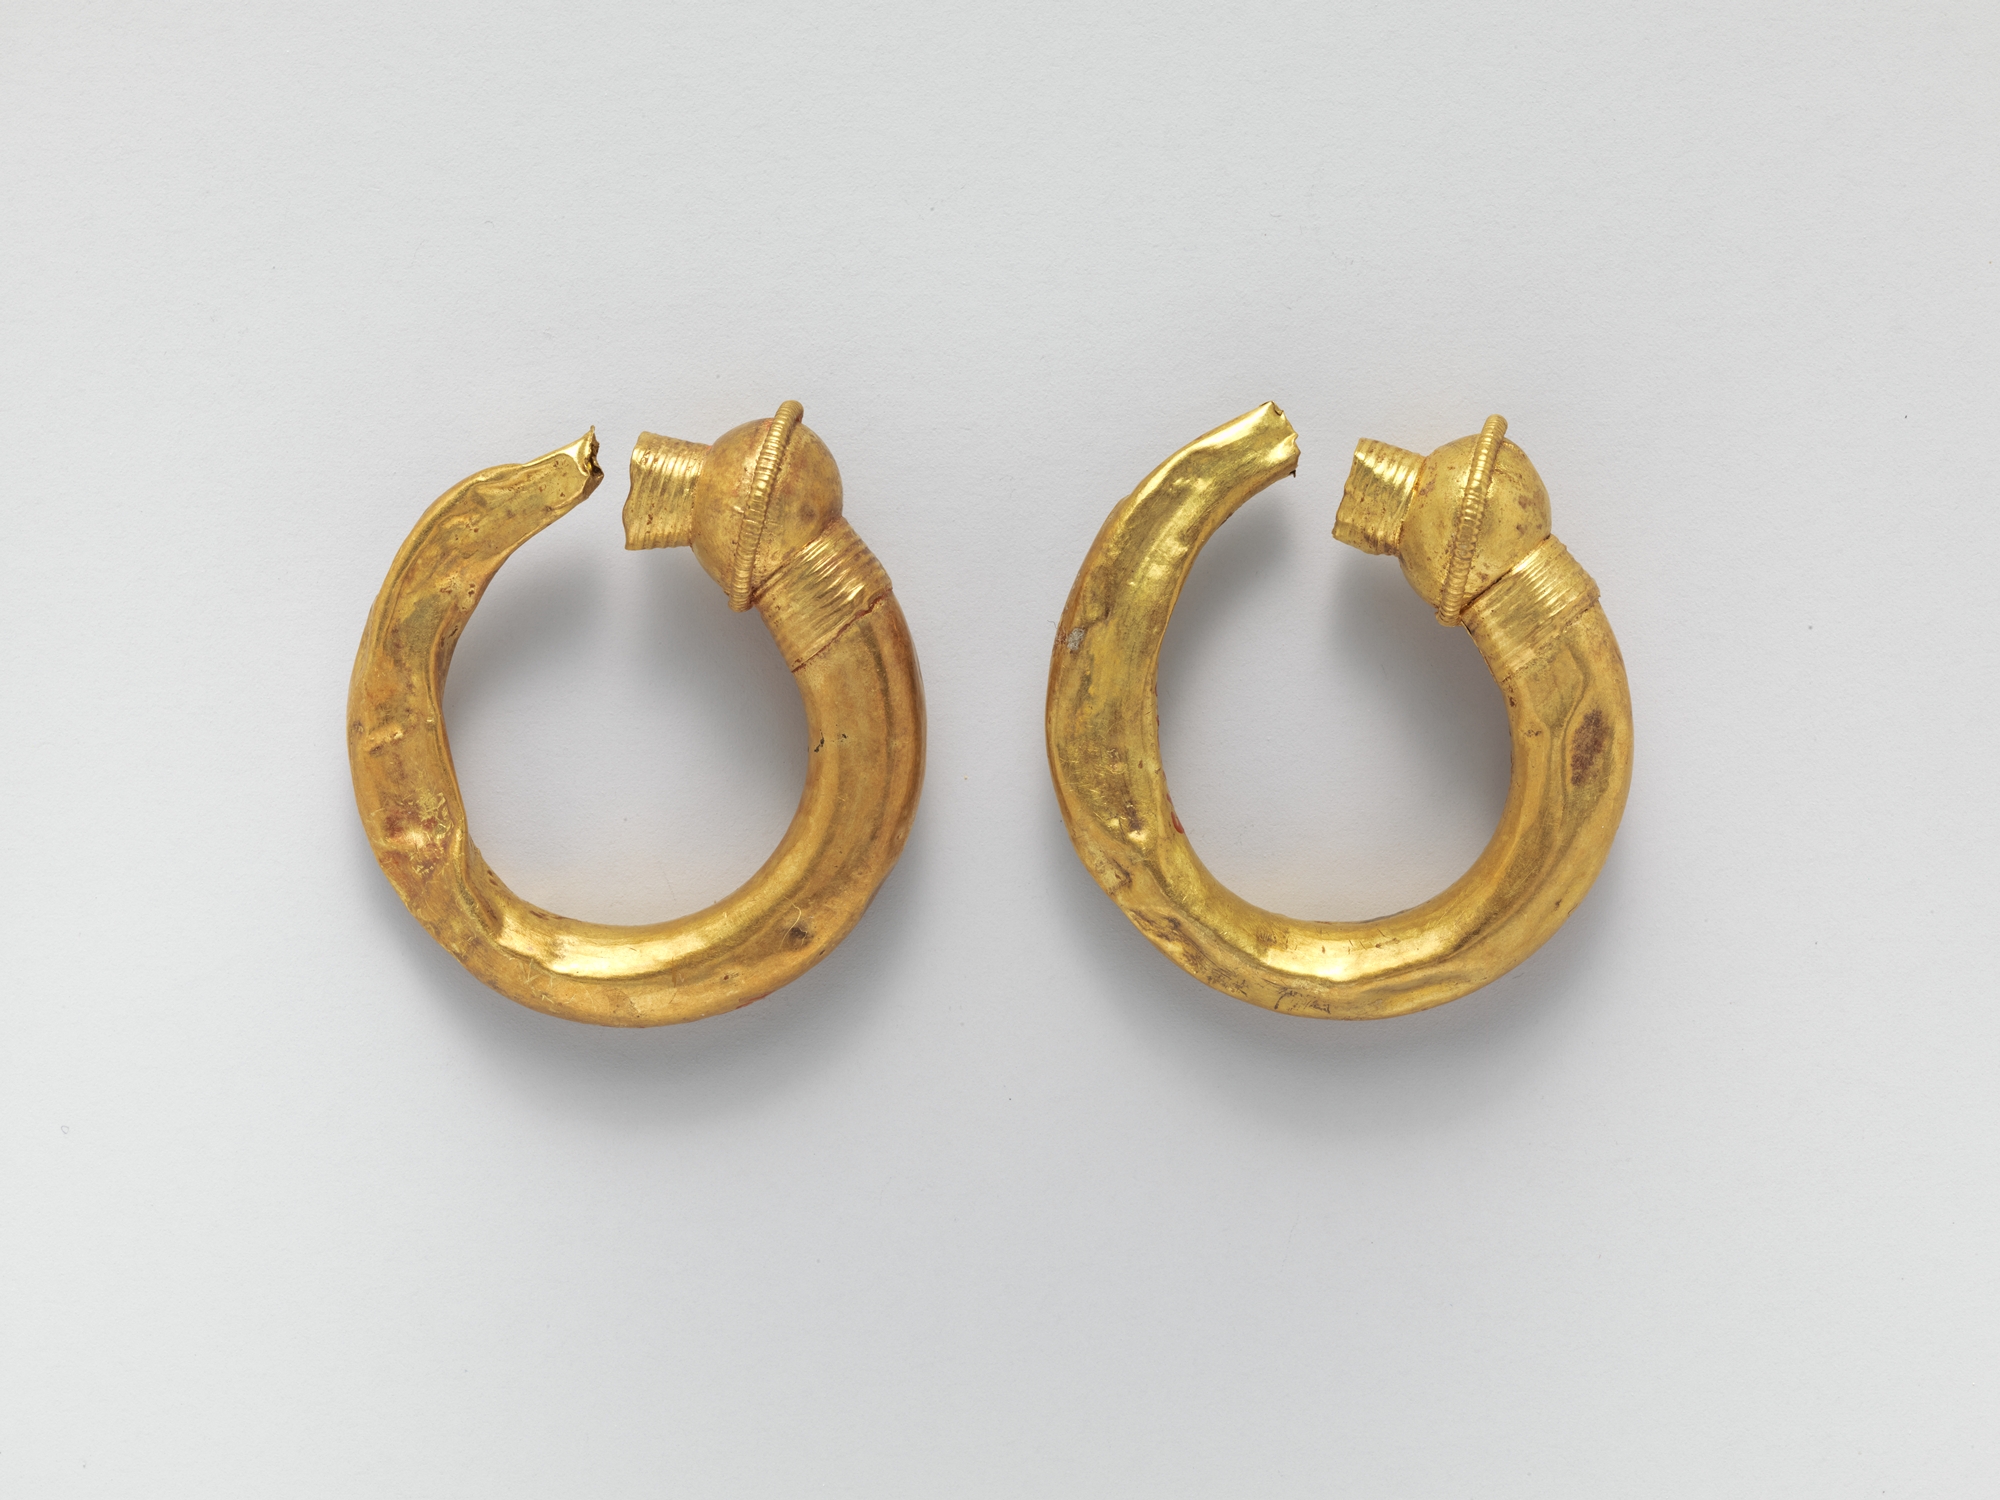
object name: earring, trumpet shaped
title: Gold trumpet-shaped earrings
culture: etruscan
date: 400-201 BCE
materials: gold